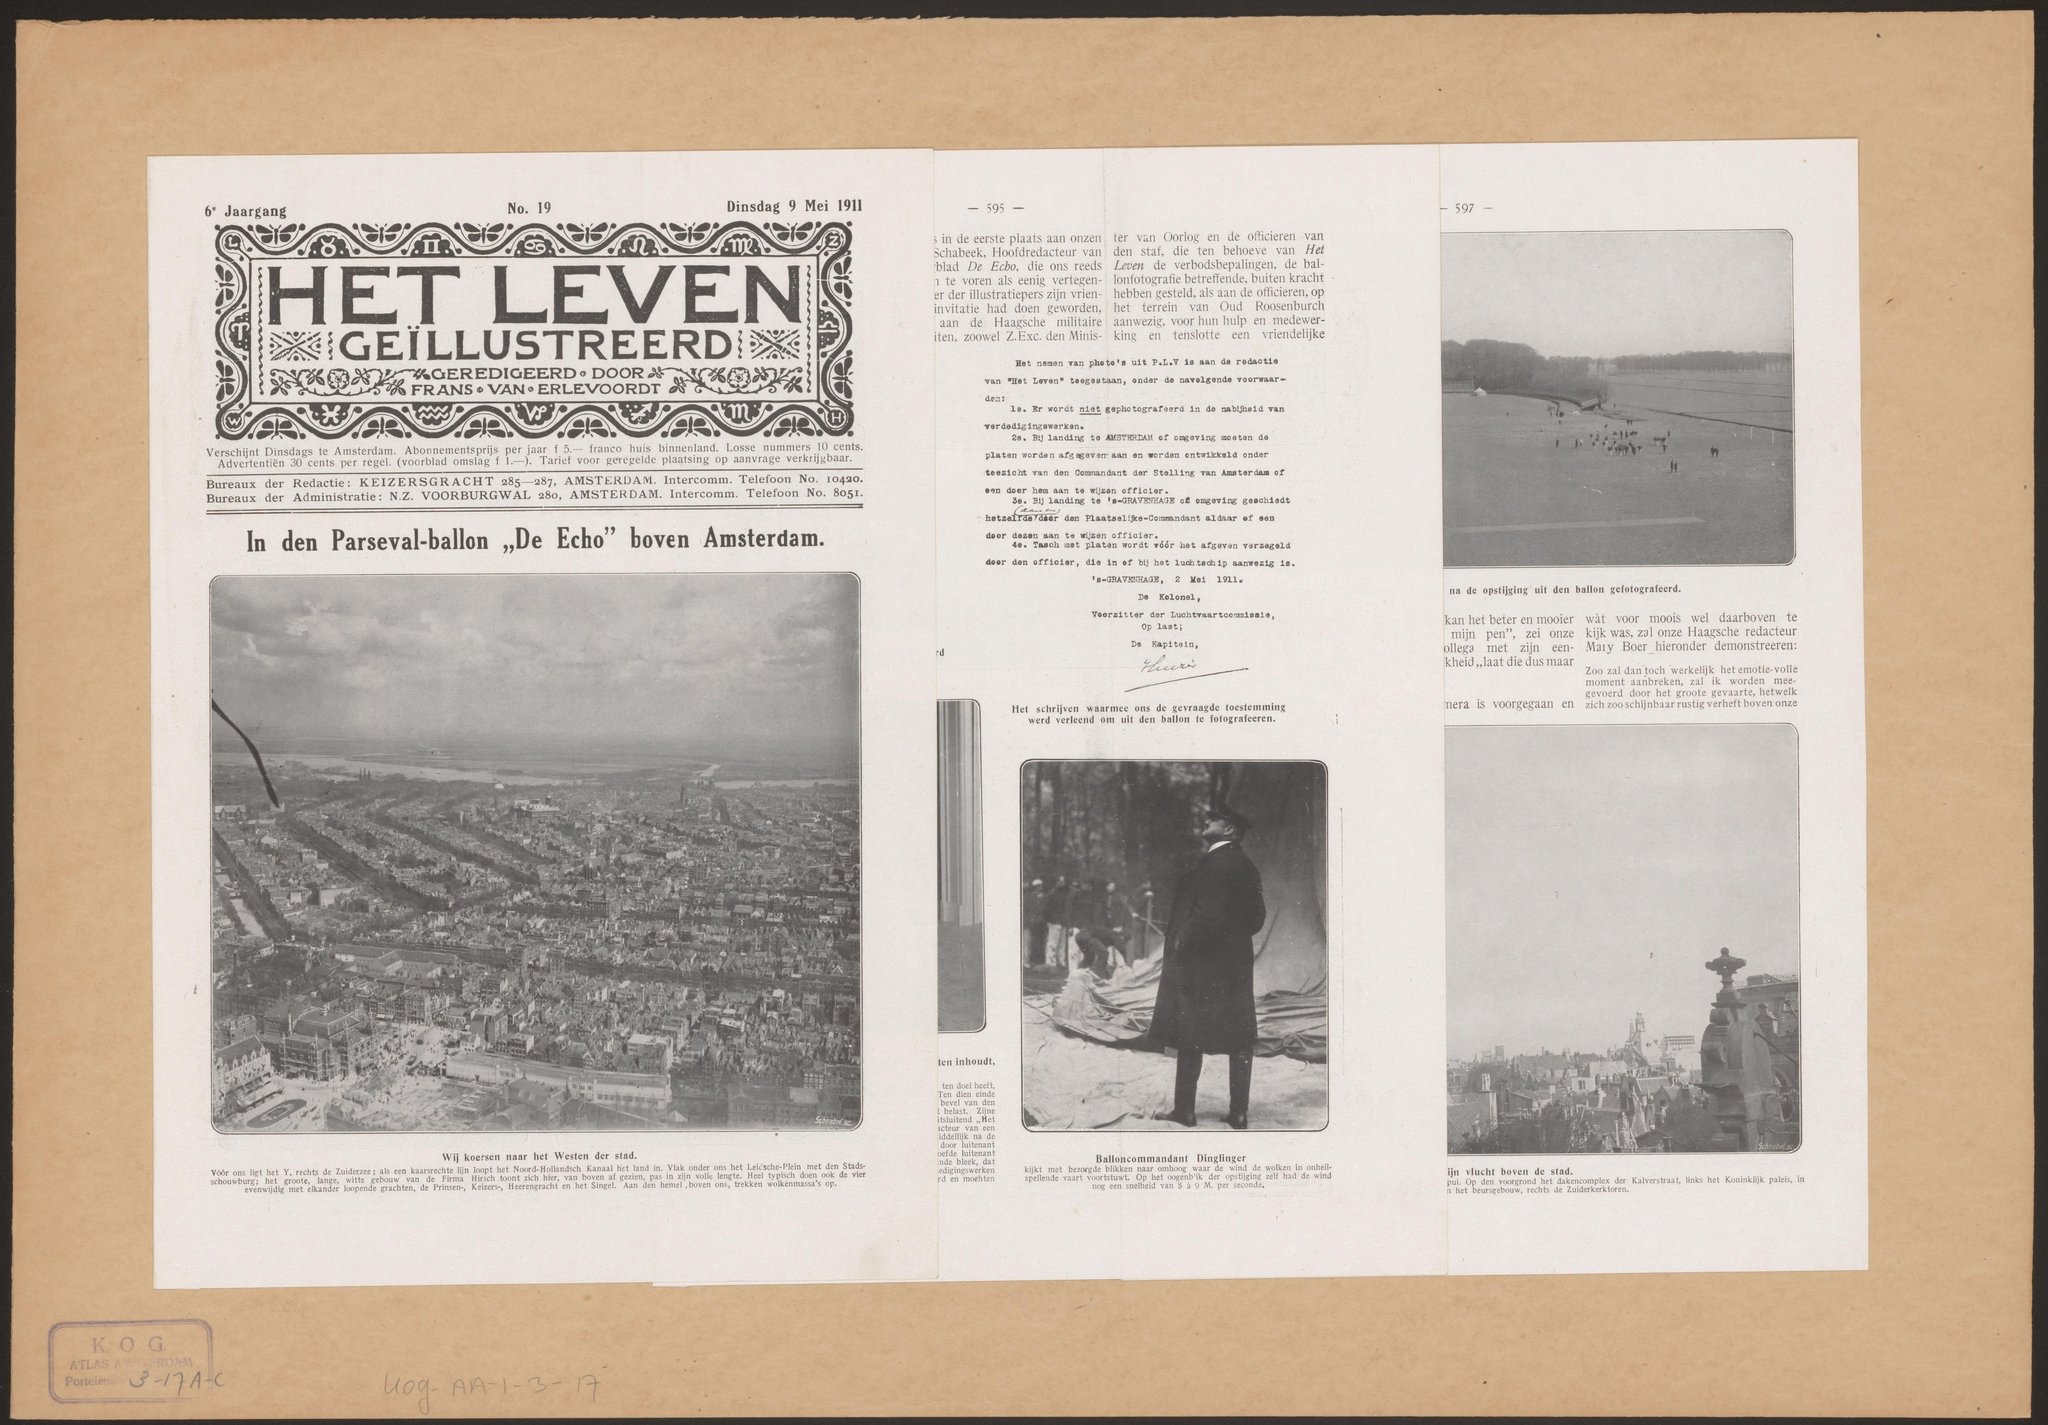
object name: photomechanical print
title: Bladzijden uit het weekblad Het Leven. Geïllustreerd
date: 1911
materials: paper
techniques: letterpress printing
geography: amsterdam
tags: prospect of city, town panorama, silhouette of city, amsterdam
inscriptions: collector's mark: ‘3-17A-C’ Lugt 1641b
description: Onderwerpsrubriek binnen de Atlas Amsterdam: Panorama's en verzamelprenten. Drie bladzijden uit het weekblad Het Leven. Geïllustreerd.